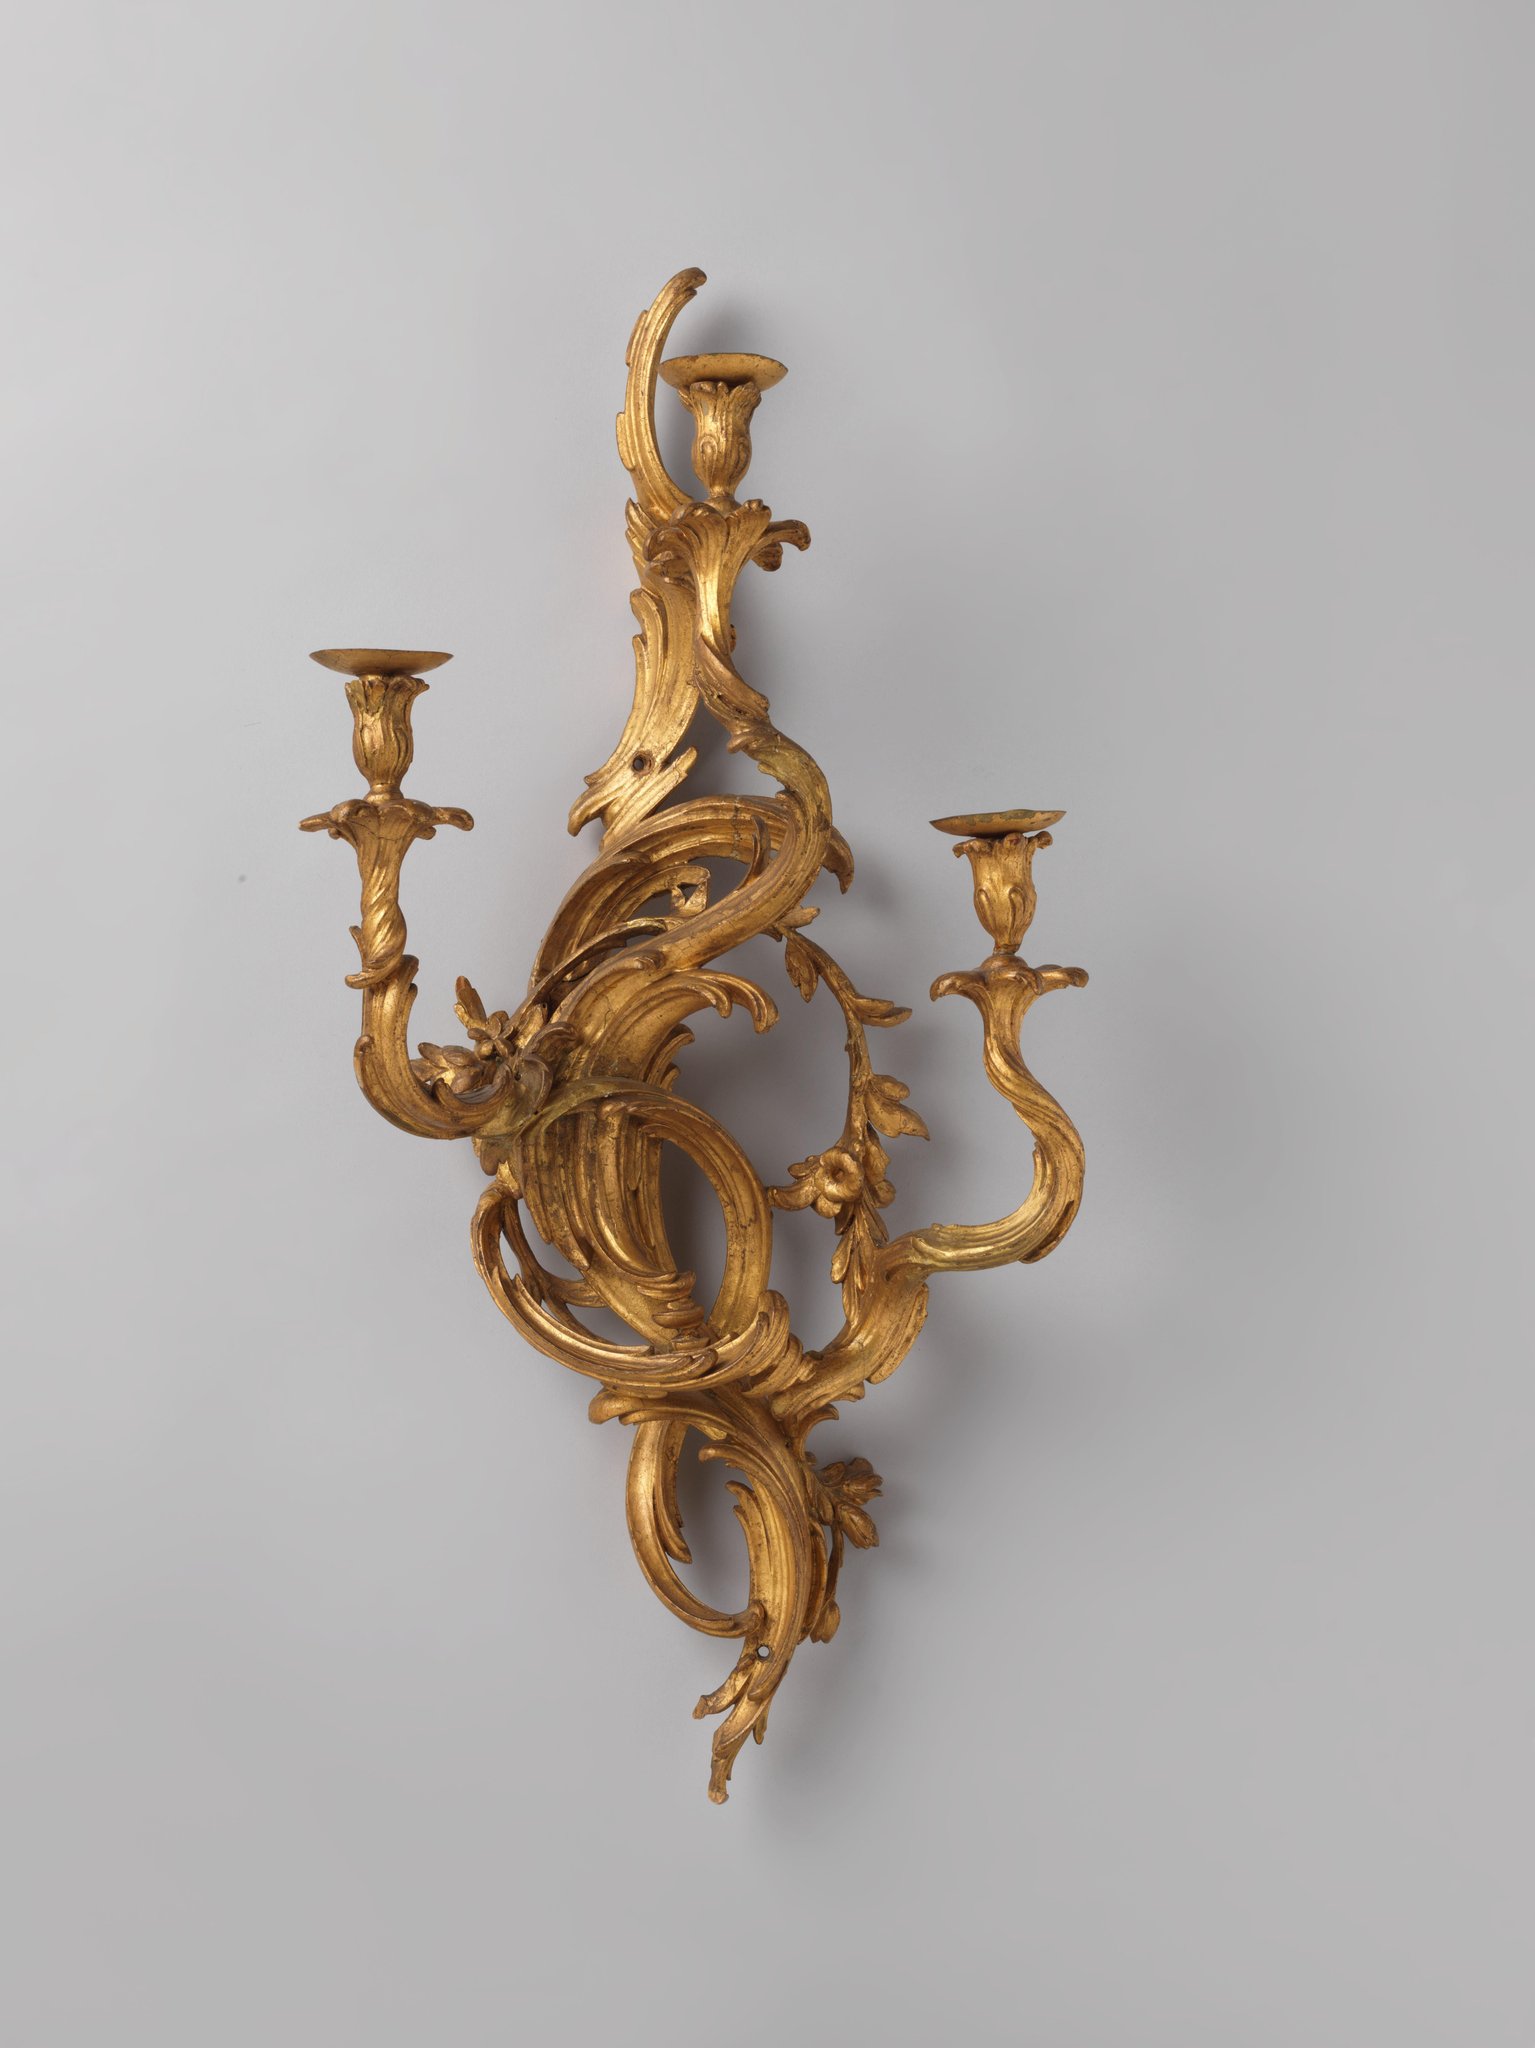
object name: lighting device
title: Wandarm van verguld lindehout met drie kaarsenhouders en decoratie van asymmetrisch gebeeldhouwd acanthusbladwerk met bloemen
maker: Anonymous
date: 1755-1770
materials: wood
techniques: cutting, gilding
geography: netherlands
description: Wandarm van verguld lindehout met drie kaarsenhouders en gedecoreerd met asymmetrisch gebeeldhouwd acanthusbladwerk met bloemen.